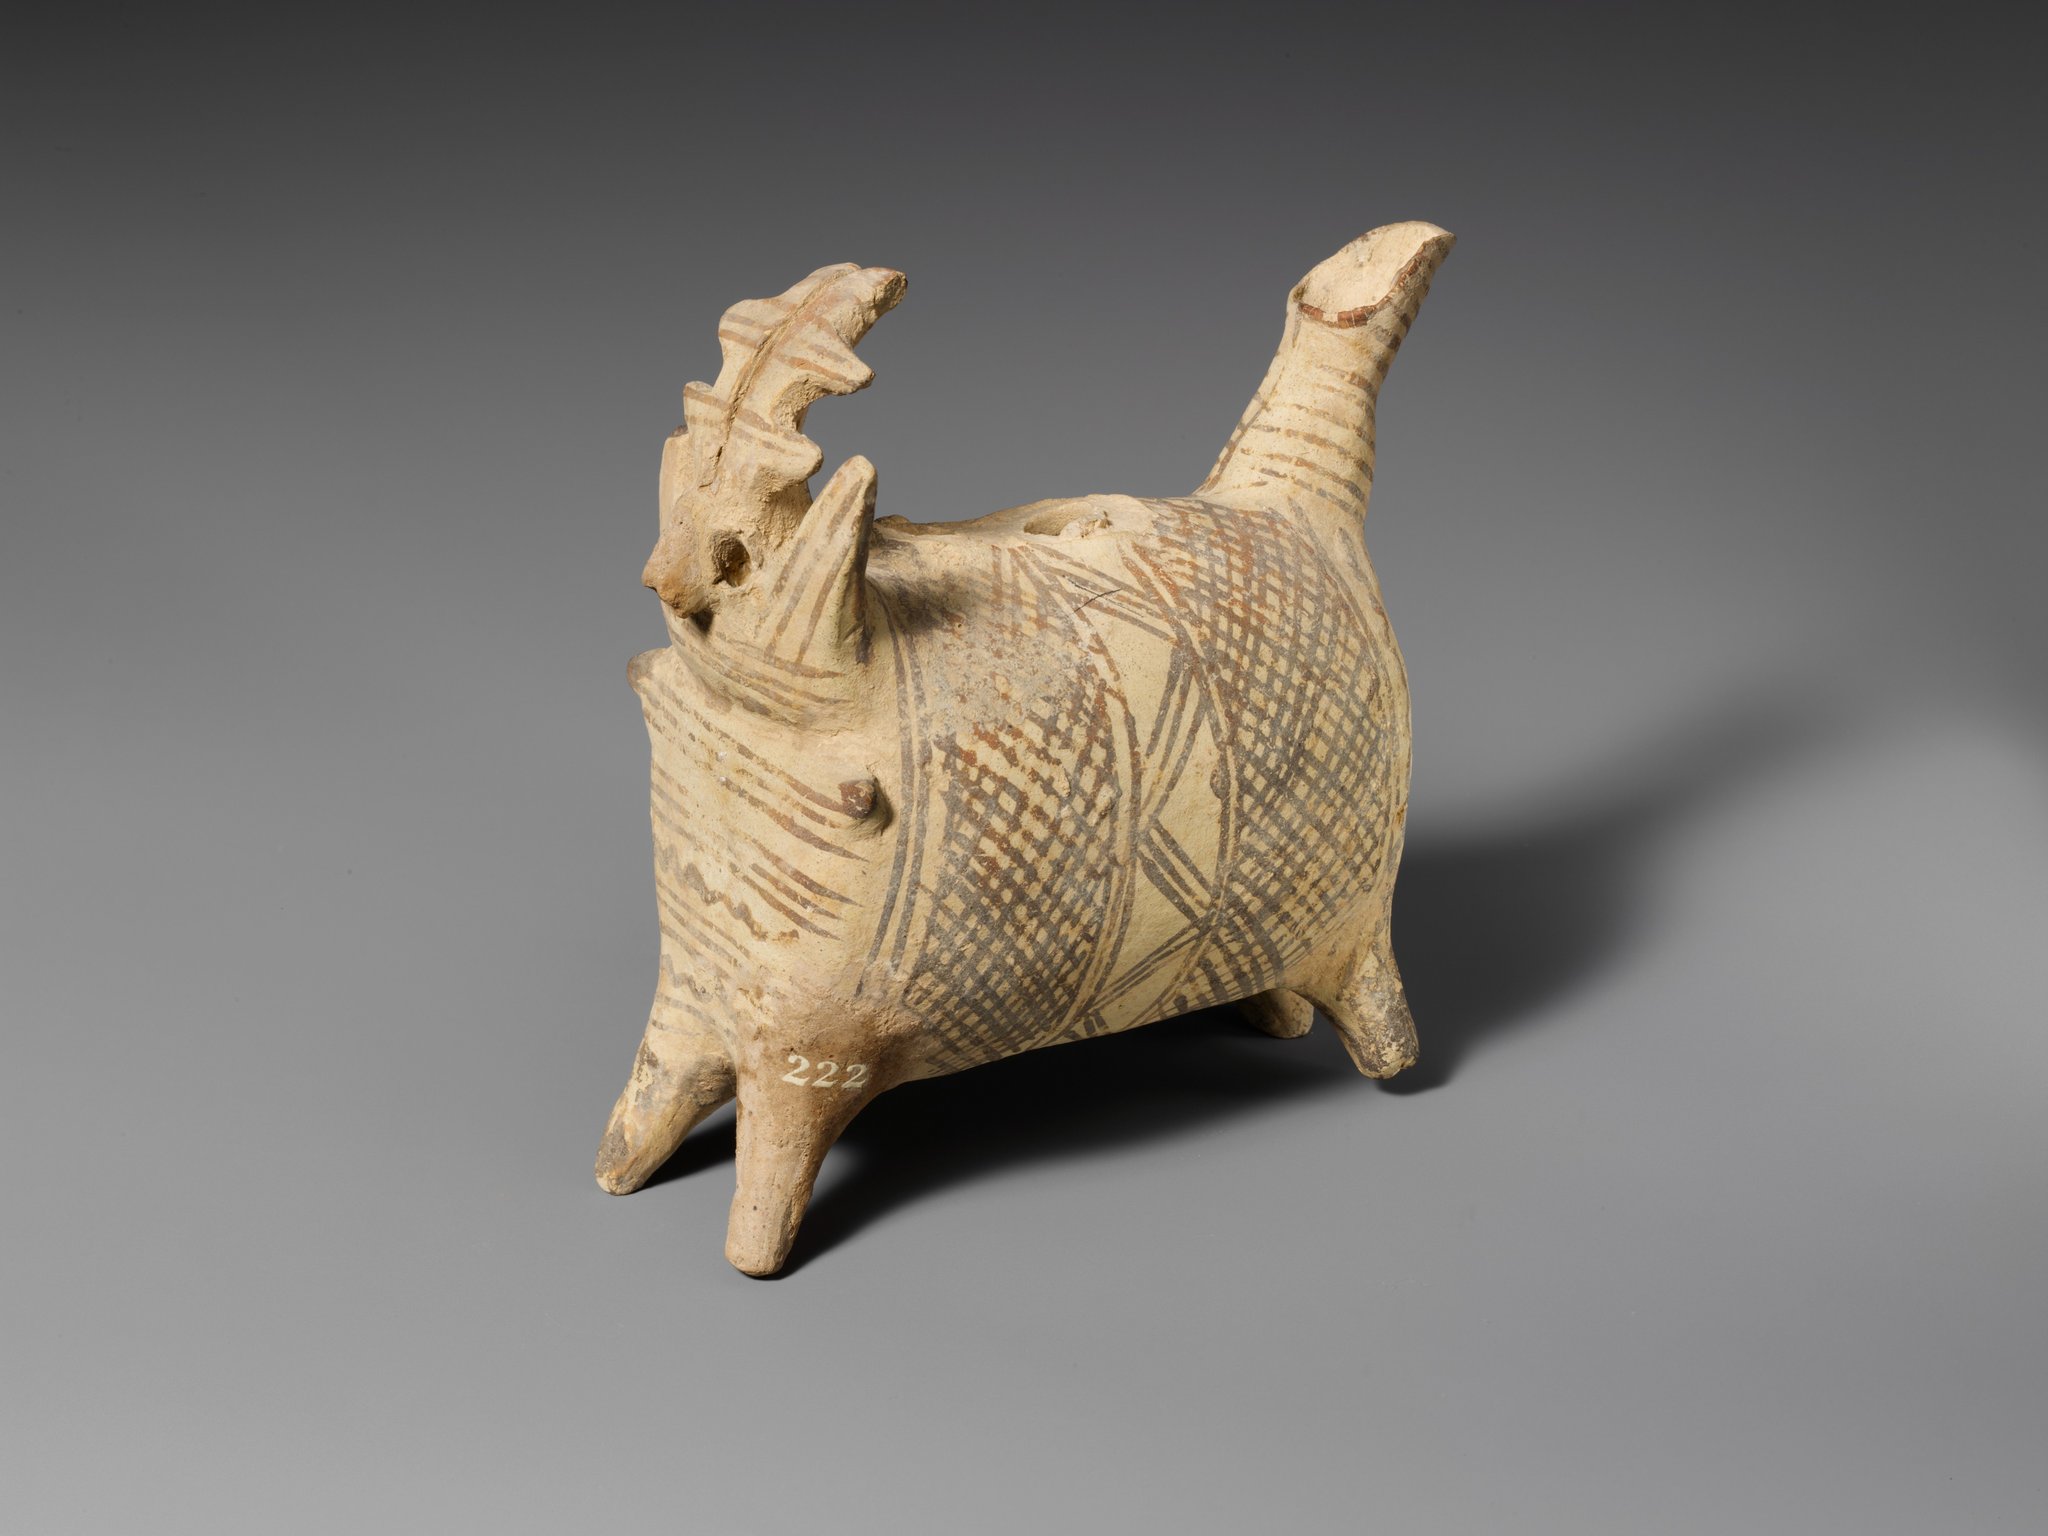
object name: askos in the form of an animal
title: Terracotta zoomorphic askos (vessel)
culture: cypriot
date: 1900-1600 BCE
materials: terracotta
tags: animals